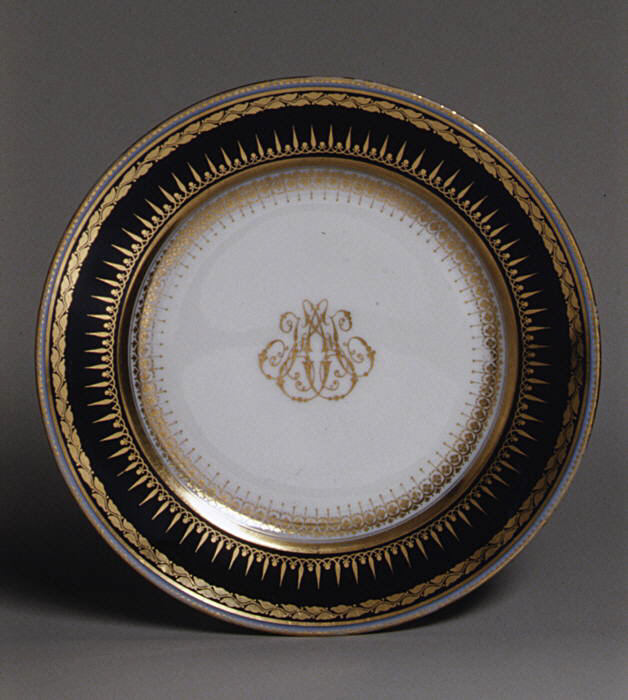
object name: plate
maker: haviland & co.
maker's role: factory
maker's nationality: american and french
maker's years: 1864-1931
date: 1876-1888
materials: hard paste porcelain